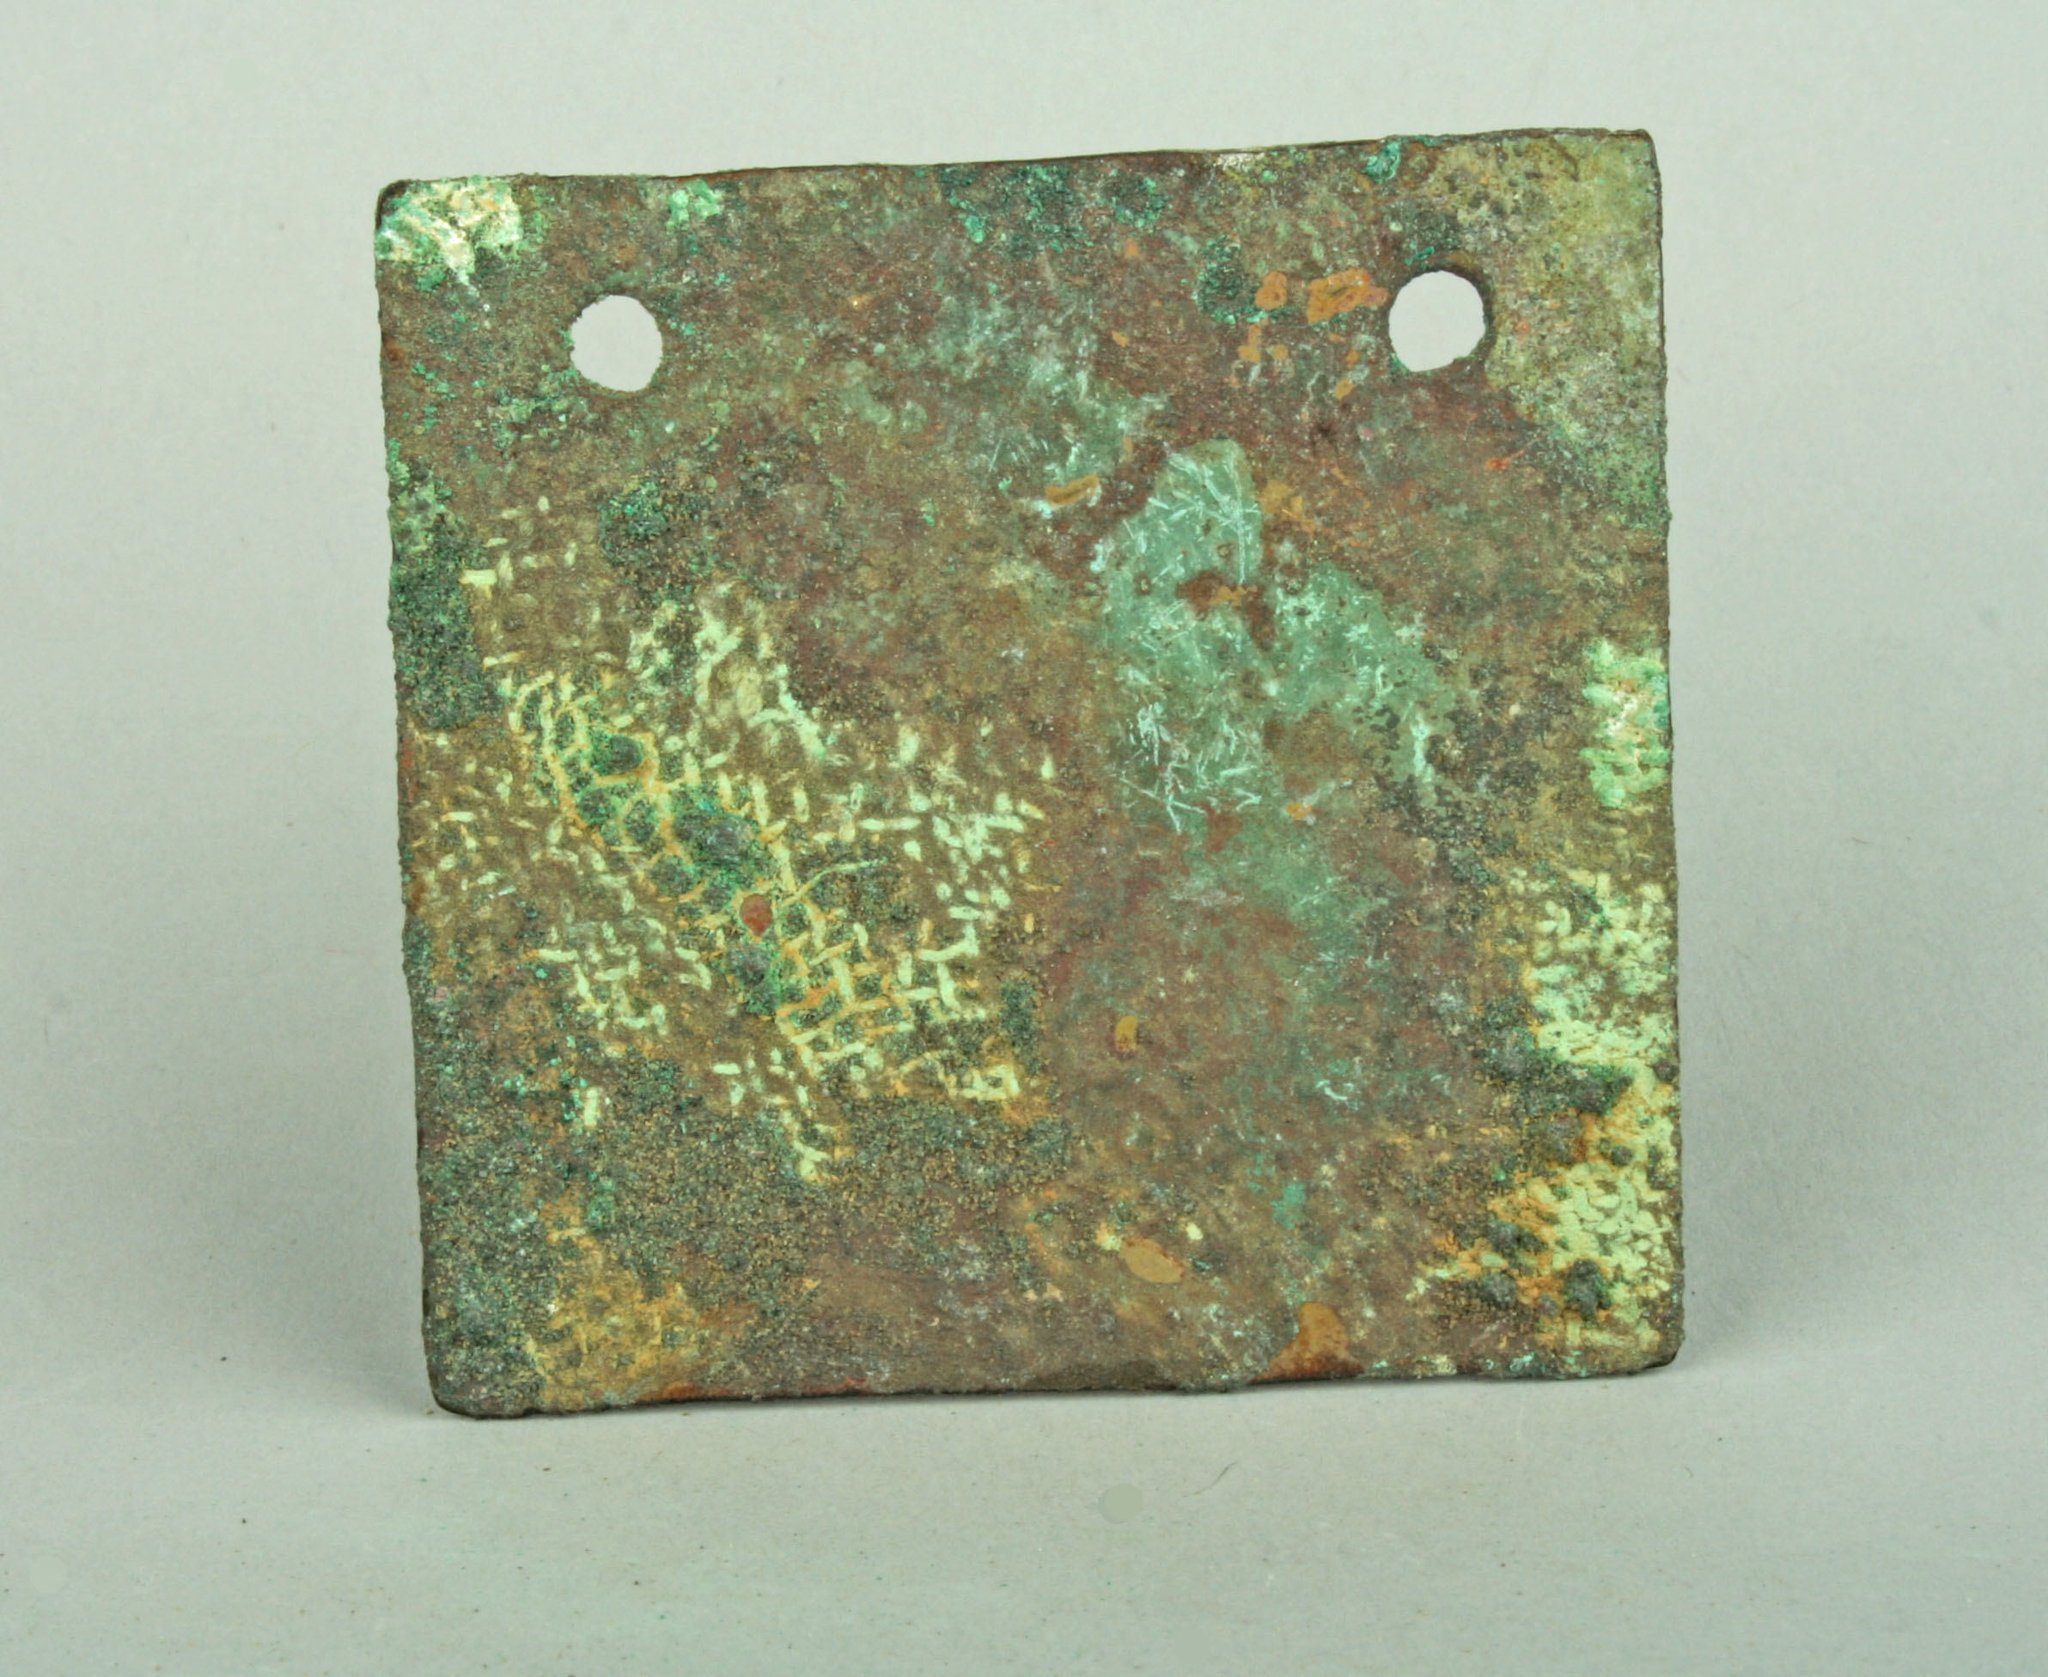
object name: plaque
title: Square Plaque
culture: vicús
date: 300 BCE-200 CE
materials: copper, gilt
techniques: hammering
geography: peru